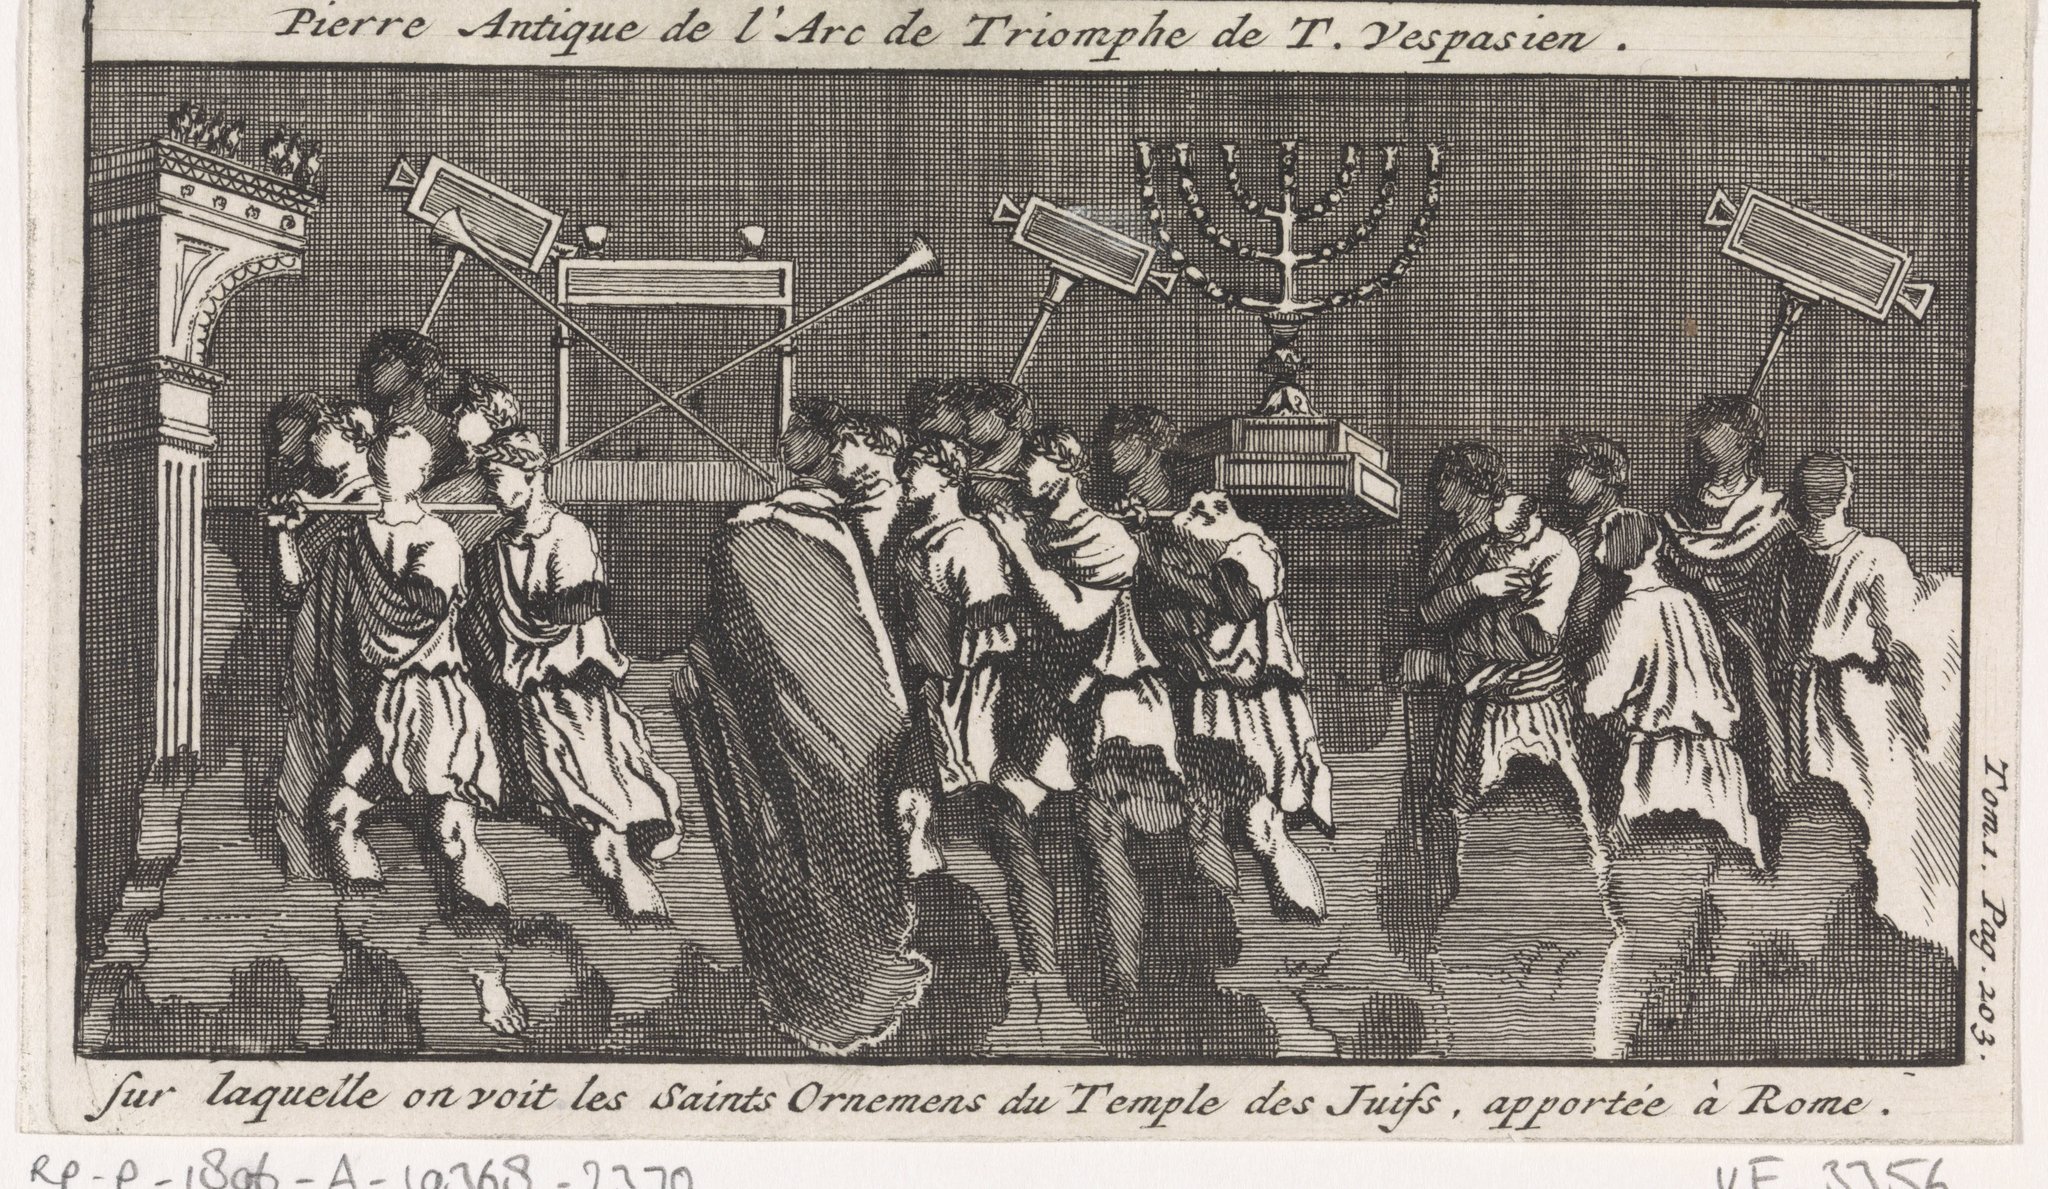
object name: print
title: Pierre antique de l'Arc de Triomphe de T. Vespasien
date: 1705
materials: paper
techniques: etching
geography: amsterdam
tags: triumphal arch, piece of sculpture, reproduction of a piece of sculpture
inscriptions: collector's mark: Lugt 2228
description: Illustratie uit: Cunaeus, Petrus. La republique des Hebreux, 3 delen. Amsterdam: Pieter Mortier, 1705, dl. I, p. 203.